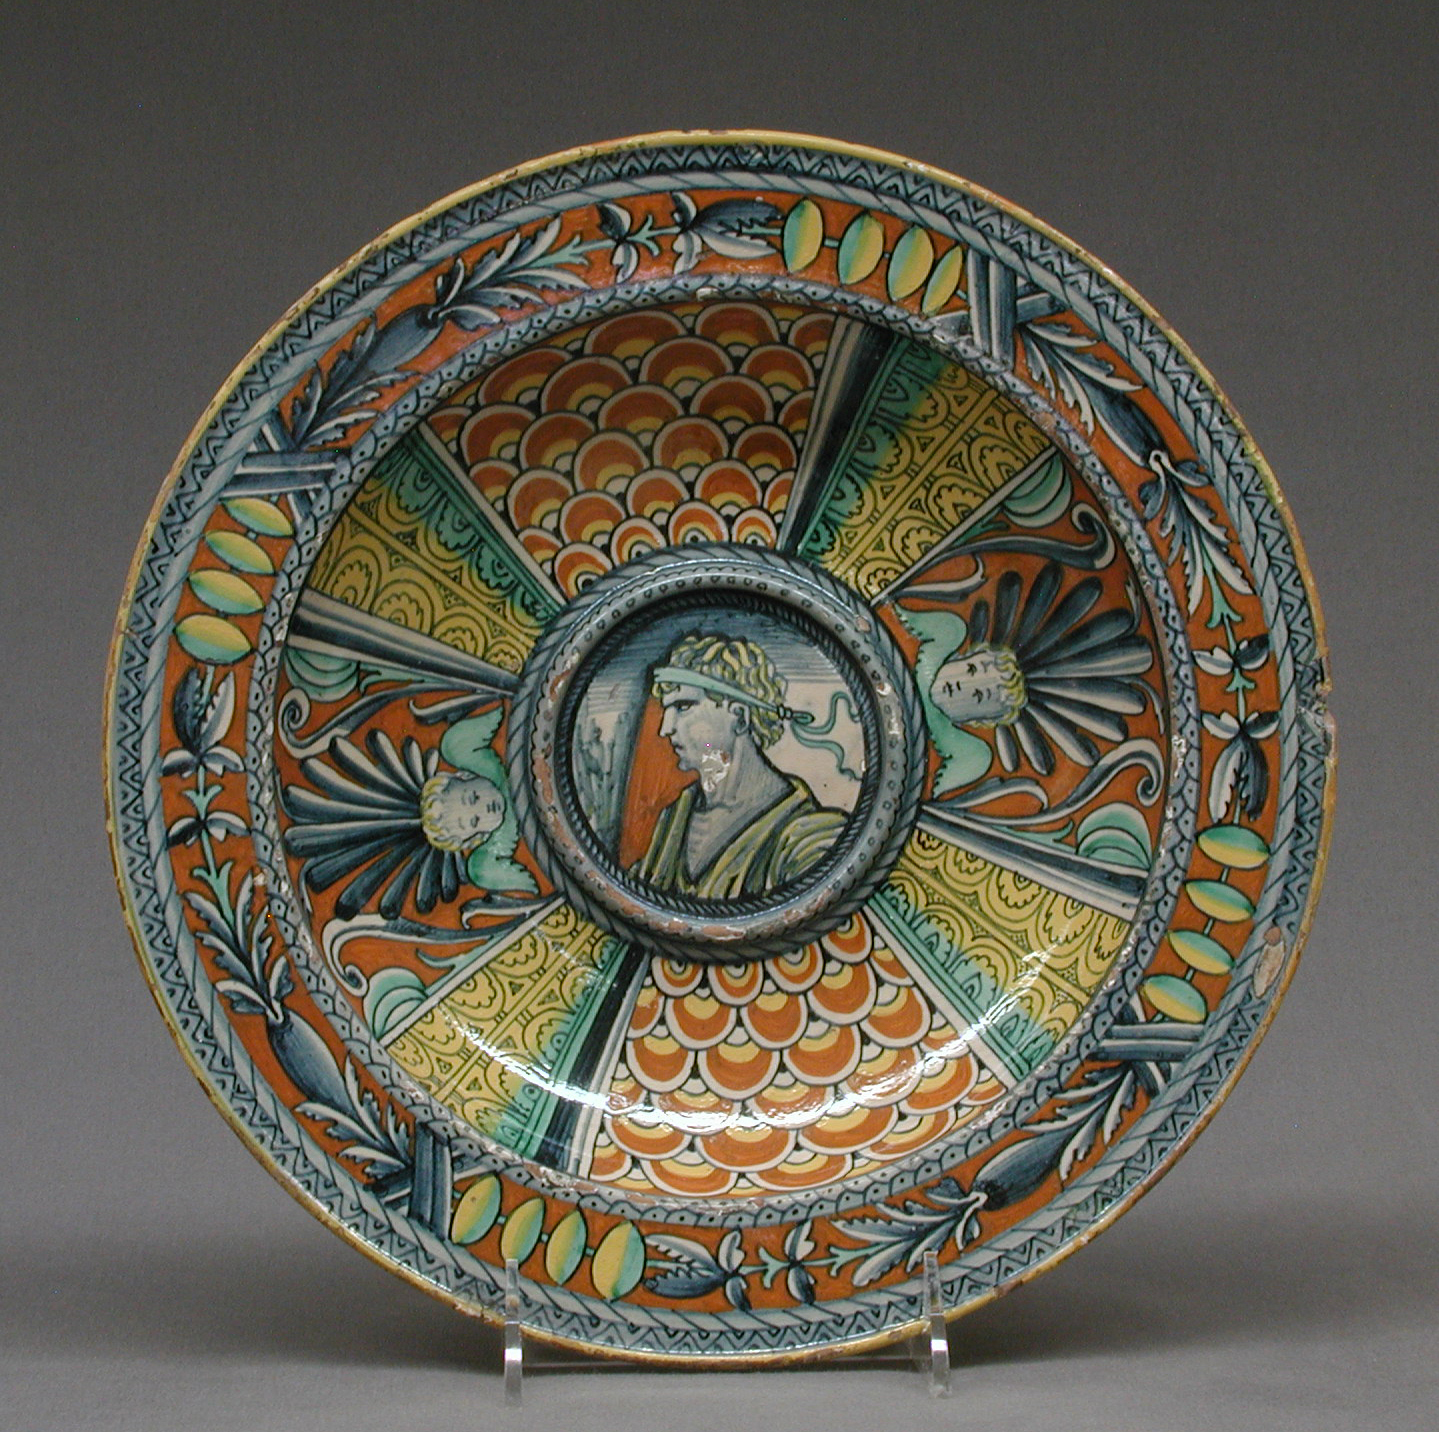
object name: dish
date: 1510-1515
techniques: maiolica, glazing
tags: profiles,flowers